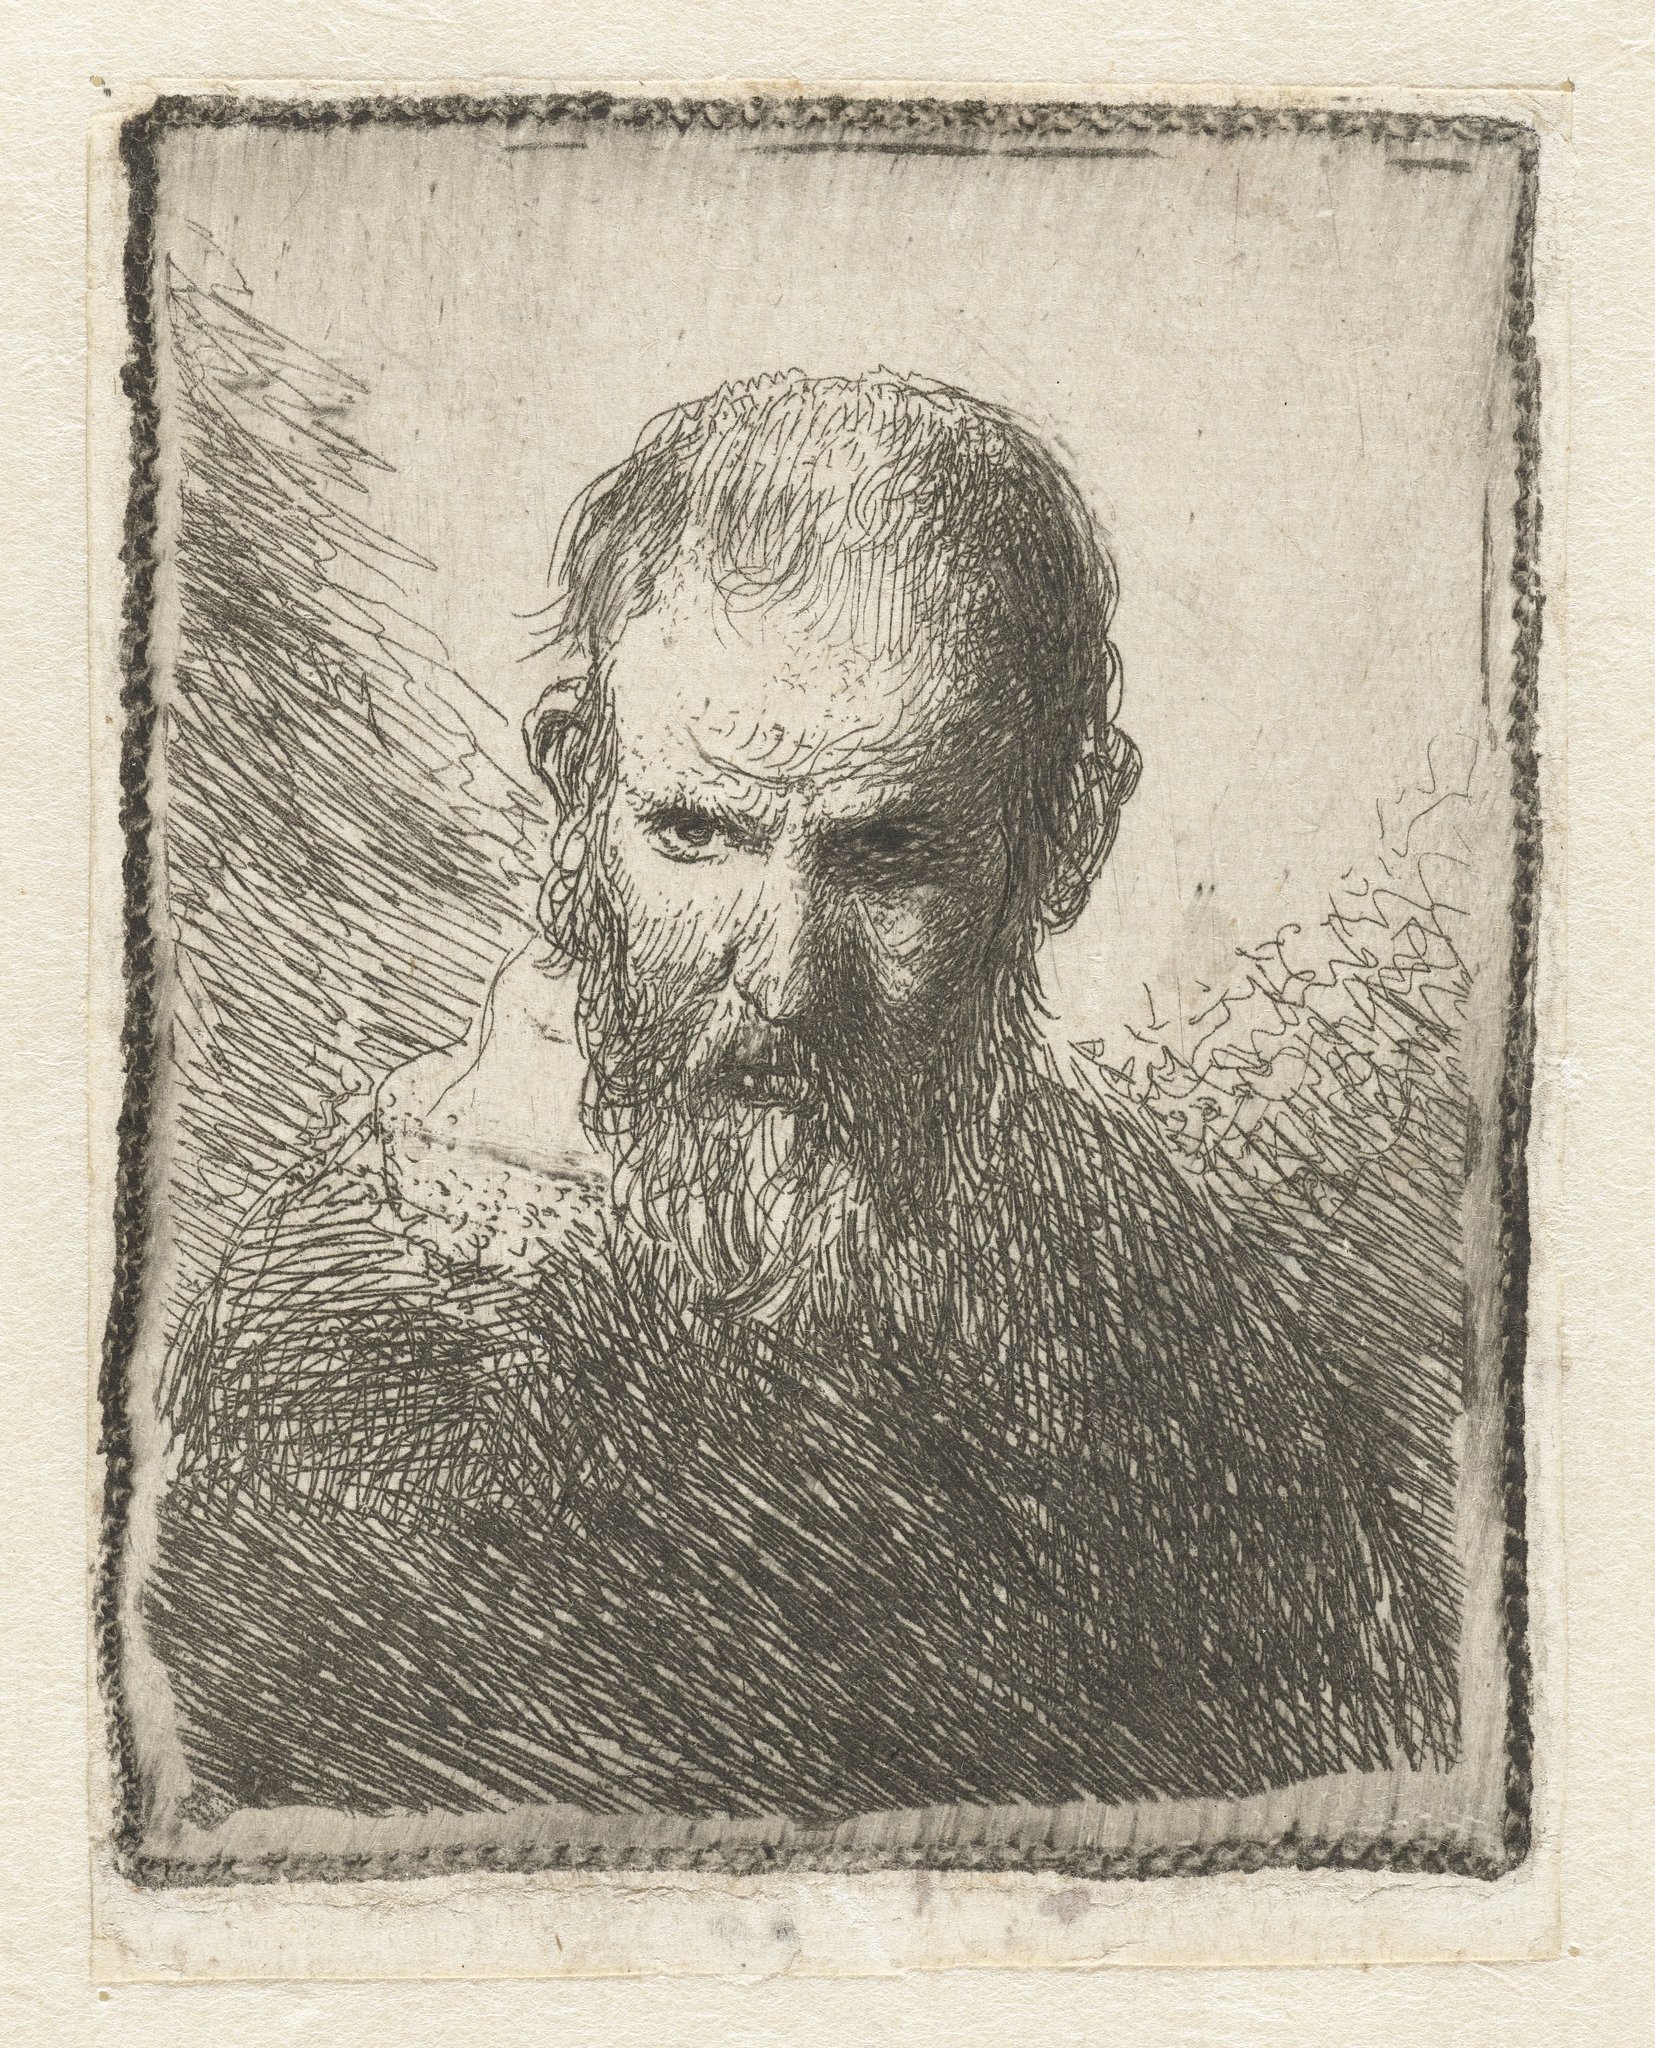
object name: print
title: Borstbeeld van een oude man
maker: jan lievens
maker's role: draughtsman, painter, print maker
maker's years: 1607-1674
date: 1625-1674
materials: paper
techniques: etching, intaglio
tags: old man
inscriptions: collector's mark: Lugt 2228a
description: De plaatrand van dit borstbeeld van een oude man heeft Lievens duidelijk niet glad afgewerkt waardoor een onregelmatig kader ontstaat waar de inkt op het ruwe oppervlak van de plaatranden bleef hangen.